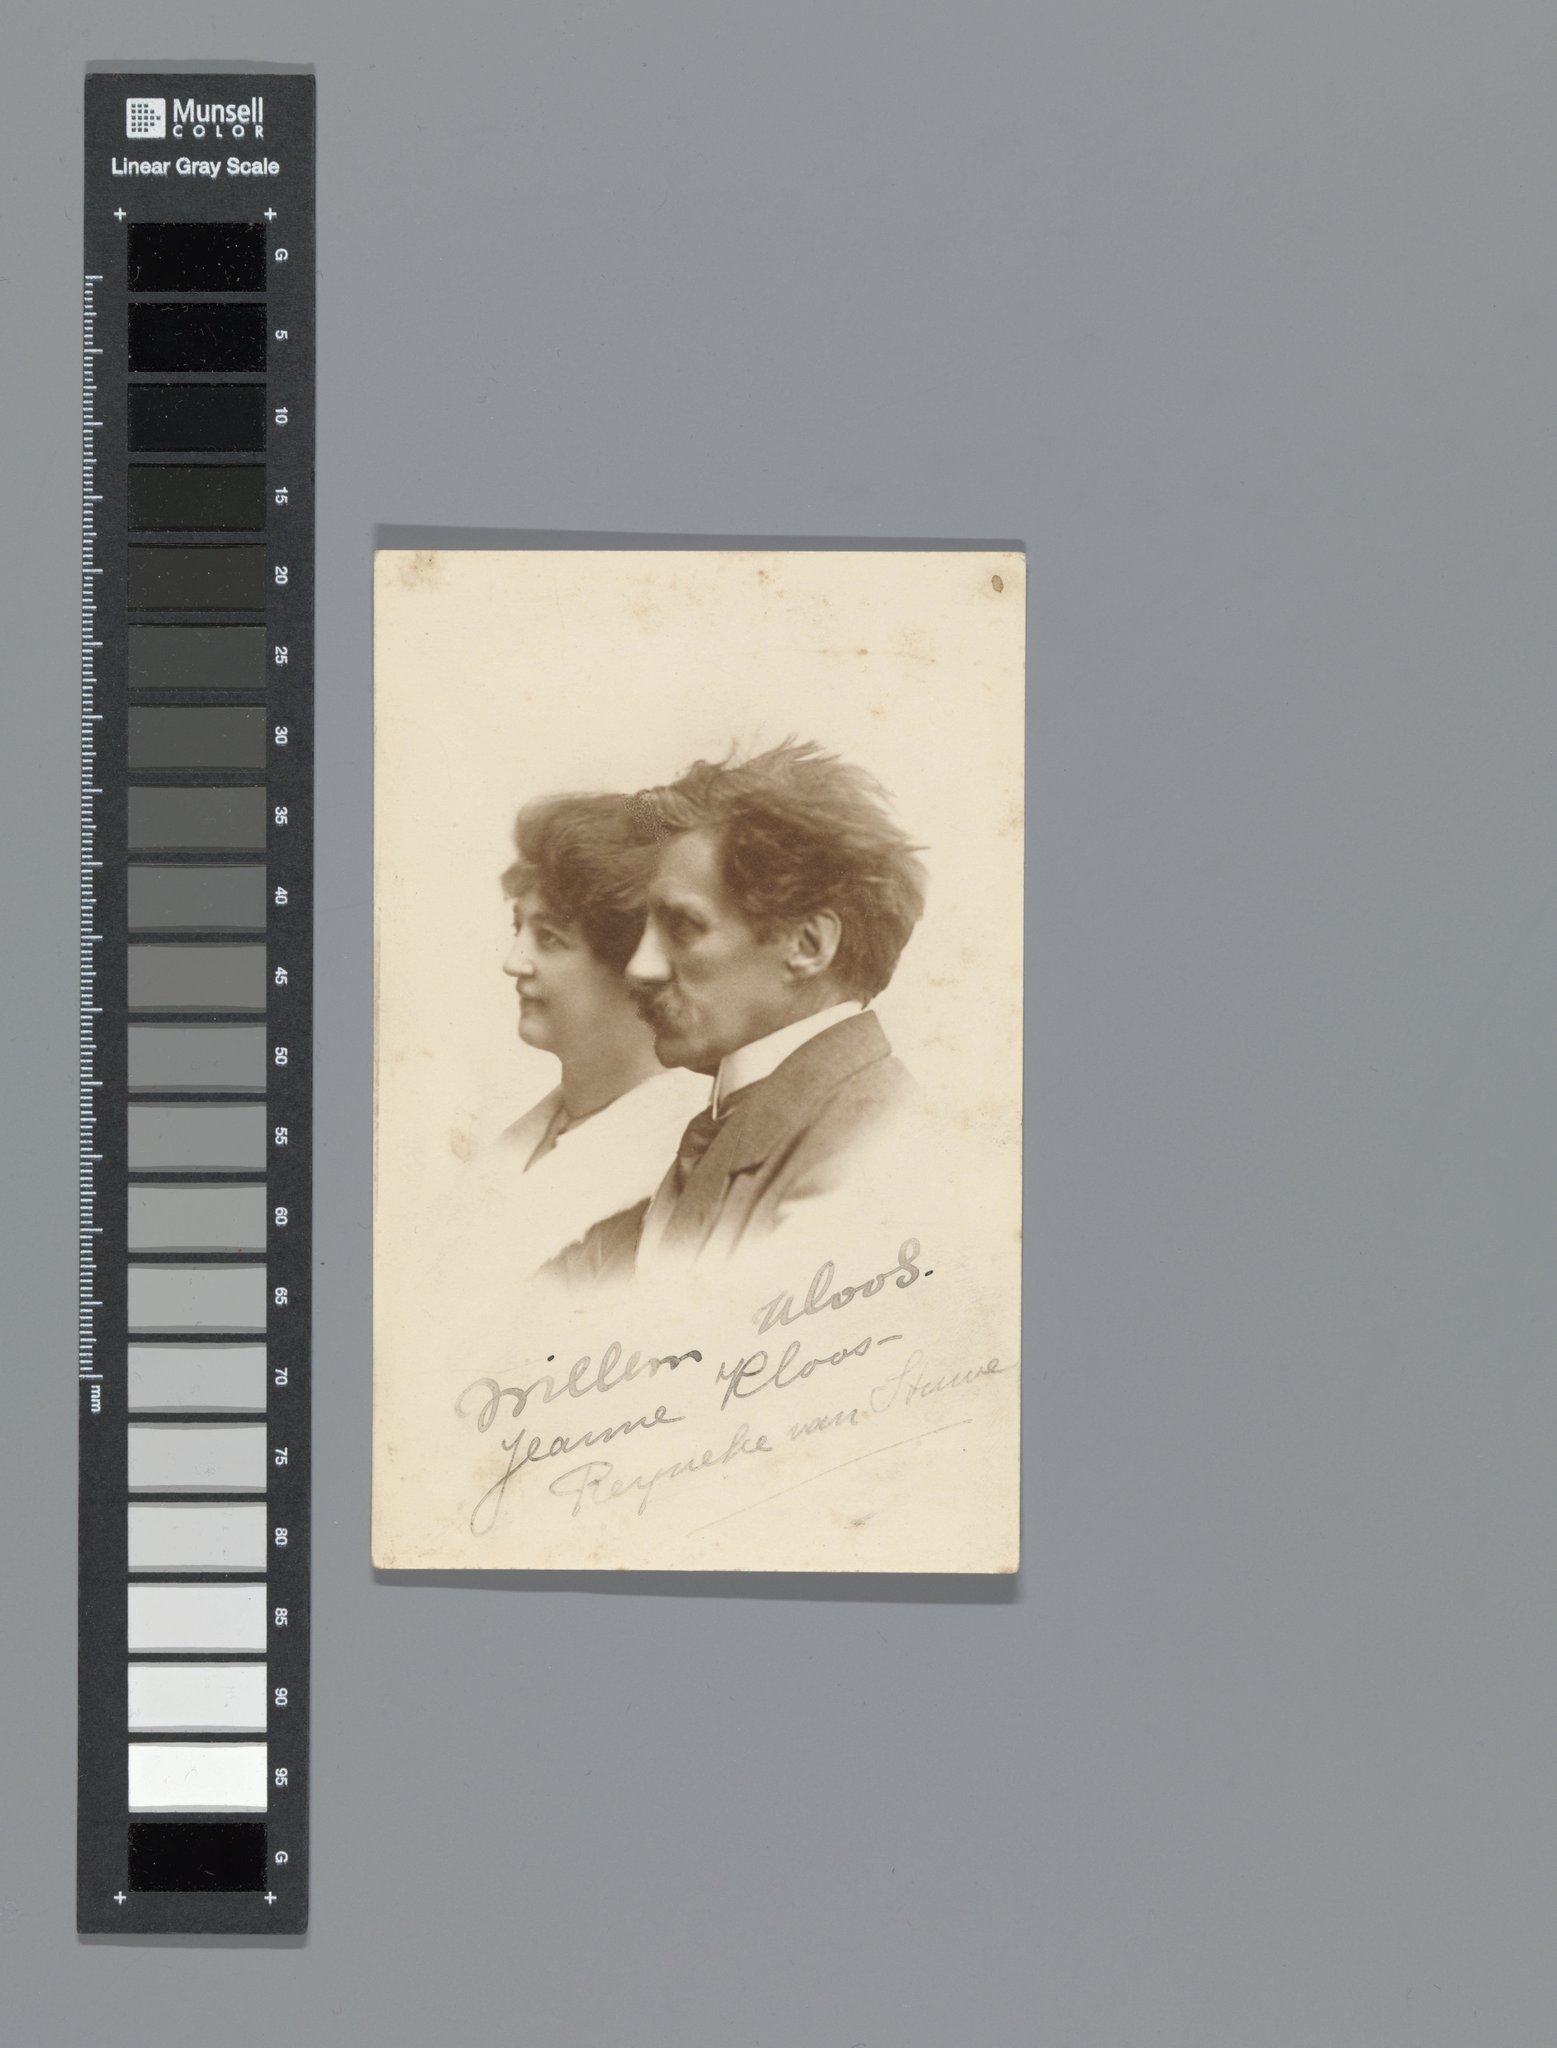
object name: photograph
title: Willem Kloos en Jeanne Kloos-Reyneke van Stuwe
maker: Anonymous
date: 1860-1915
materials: paper, photographic support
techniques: gelatin silver print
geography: netherlands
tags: the hague, willem kloos, jeanne henriette reine reyneke van stuwe, netherlands